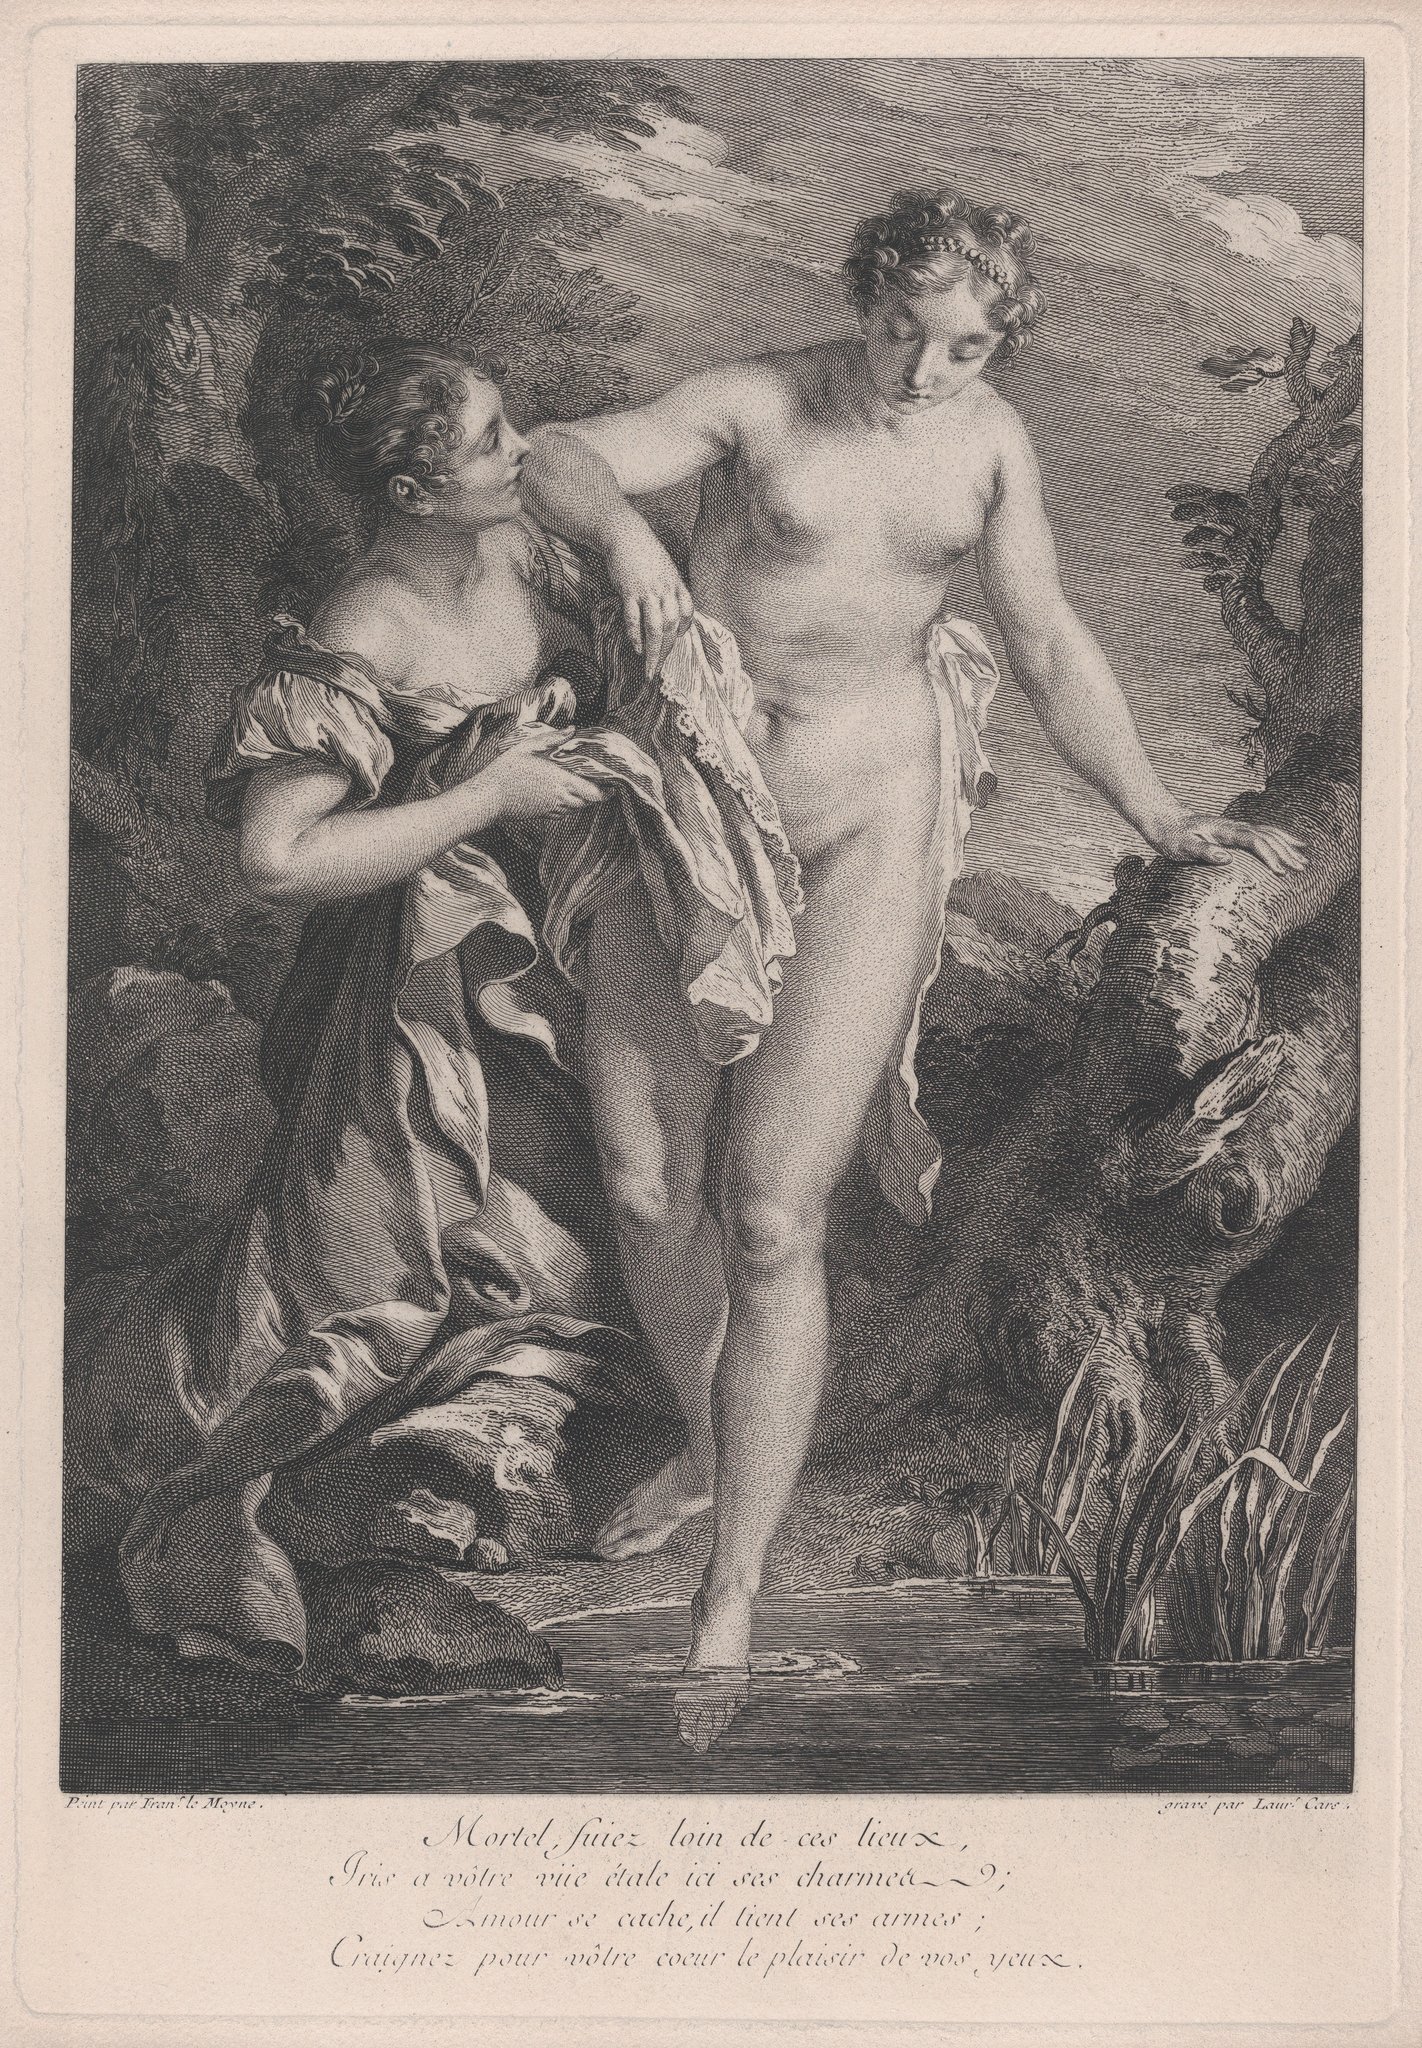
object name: print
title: Iris at the Bath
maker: laurent cars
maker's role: artist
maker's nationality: french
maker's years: 1699-1771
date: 1731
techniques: engraving, etching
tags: women,female nudes,bathing